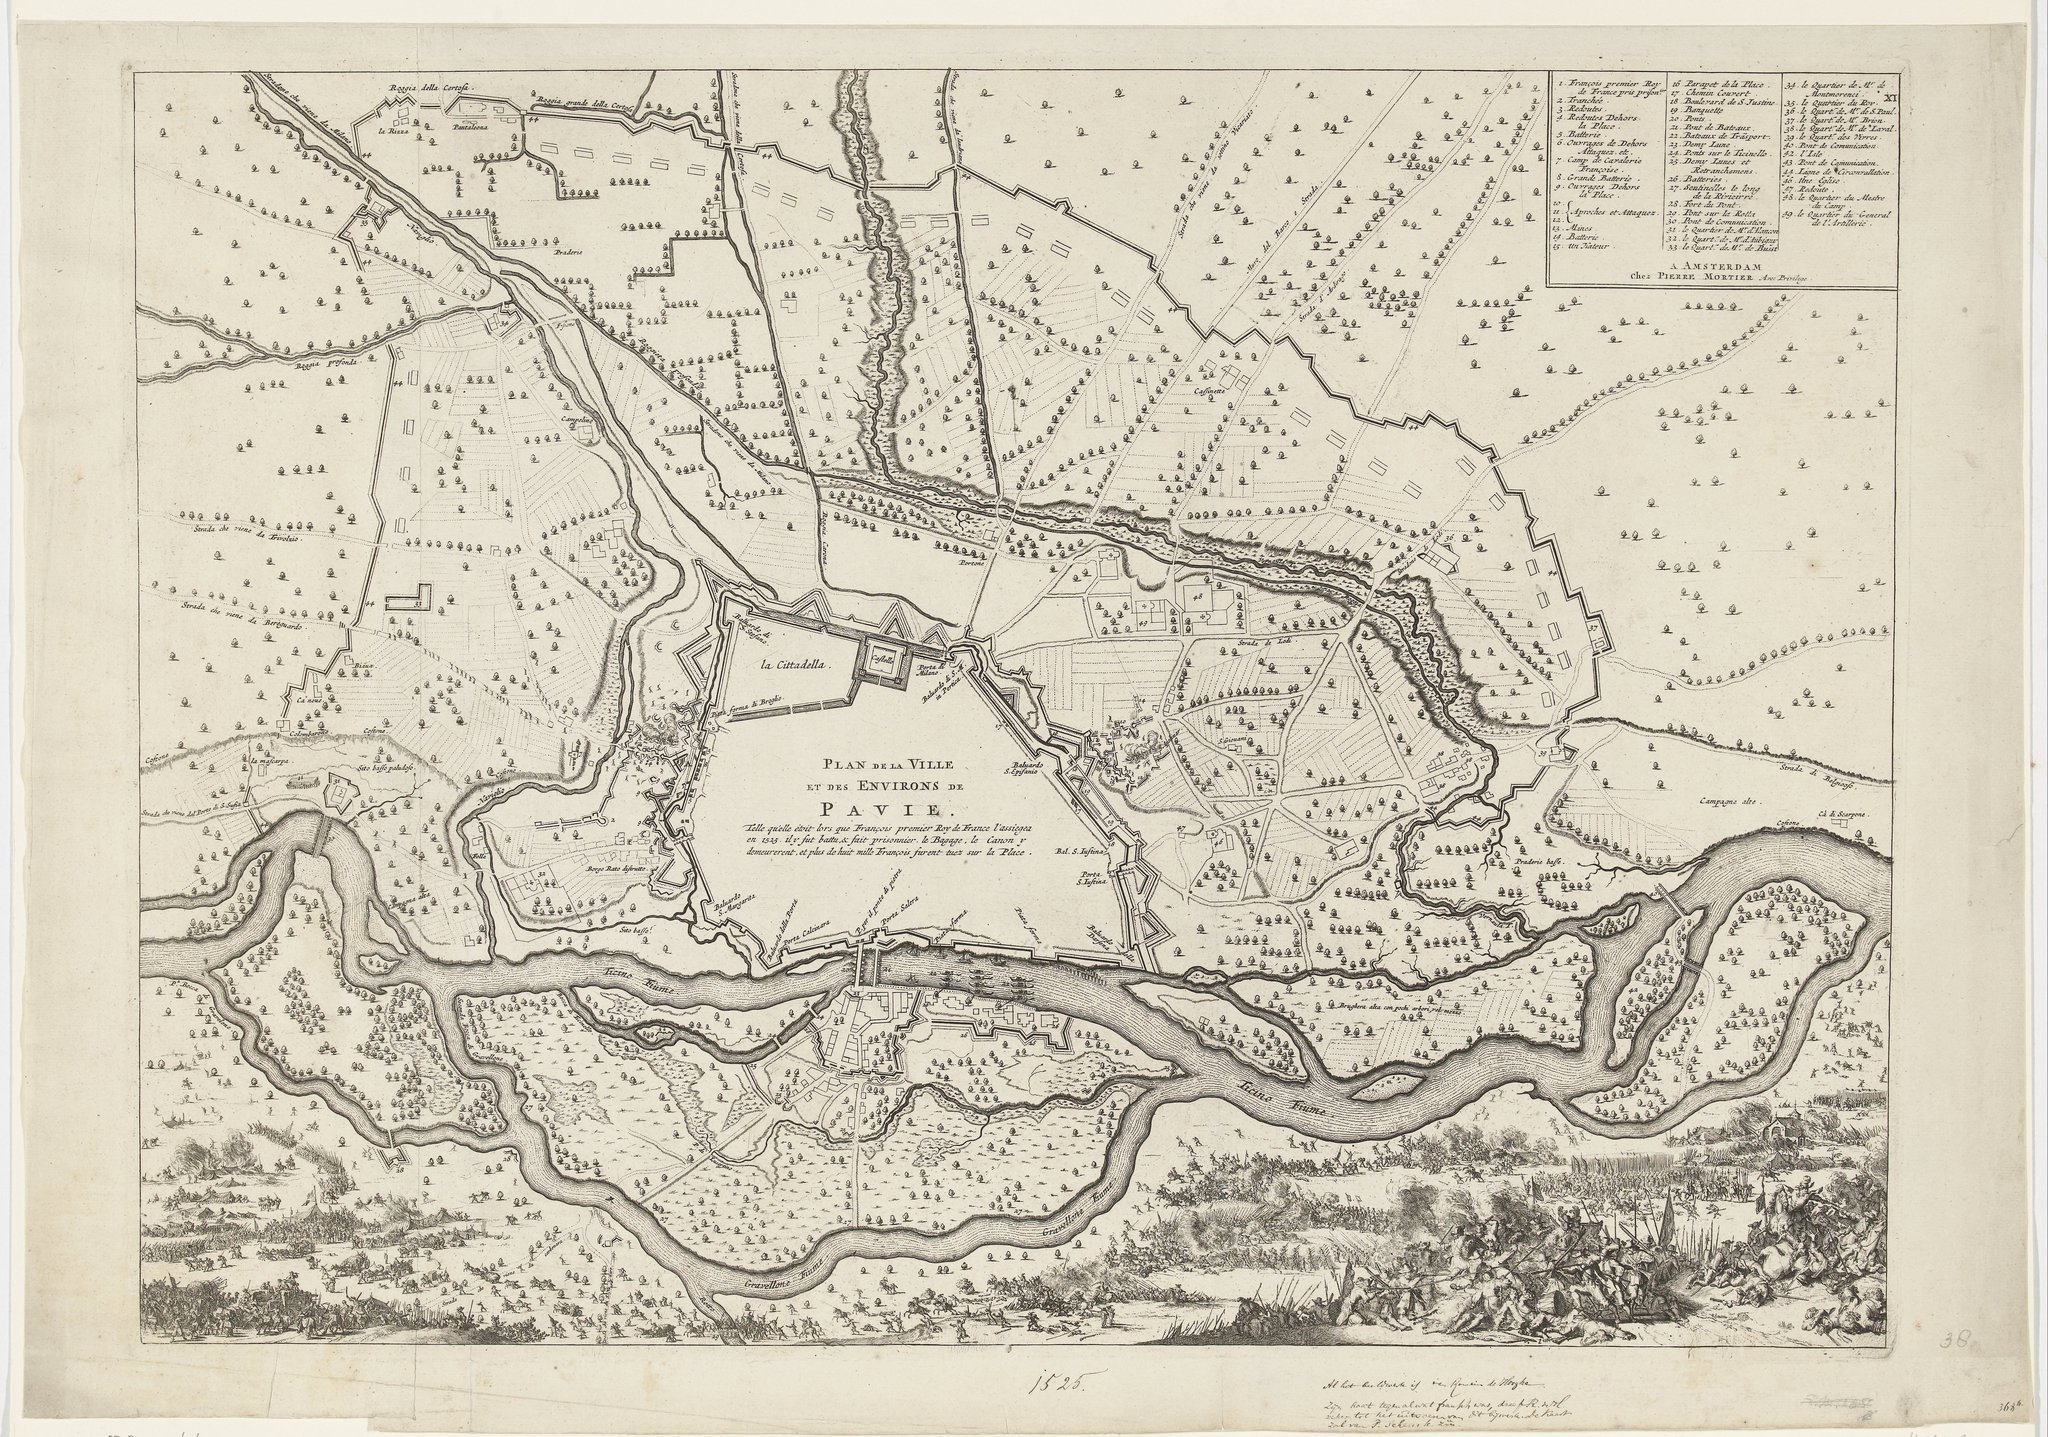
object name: history print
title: Plattegrond van Pavia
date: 1655-1708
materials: paper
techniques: etching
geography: amsterdam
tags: frans i van valois-angoulême (koning van frankrijk), siege, position war, battle, fighting in general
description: Plattegrond van Pavia na het beleg en de gevangenneming van koning Frans I van Frankrijk in 1525.